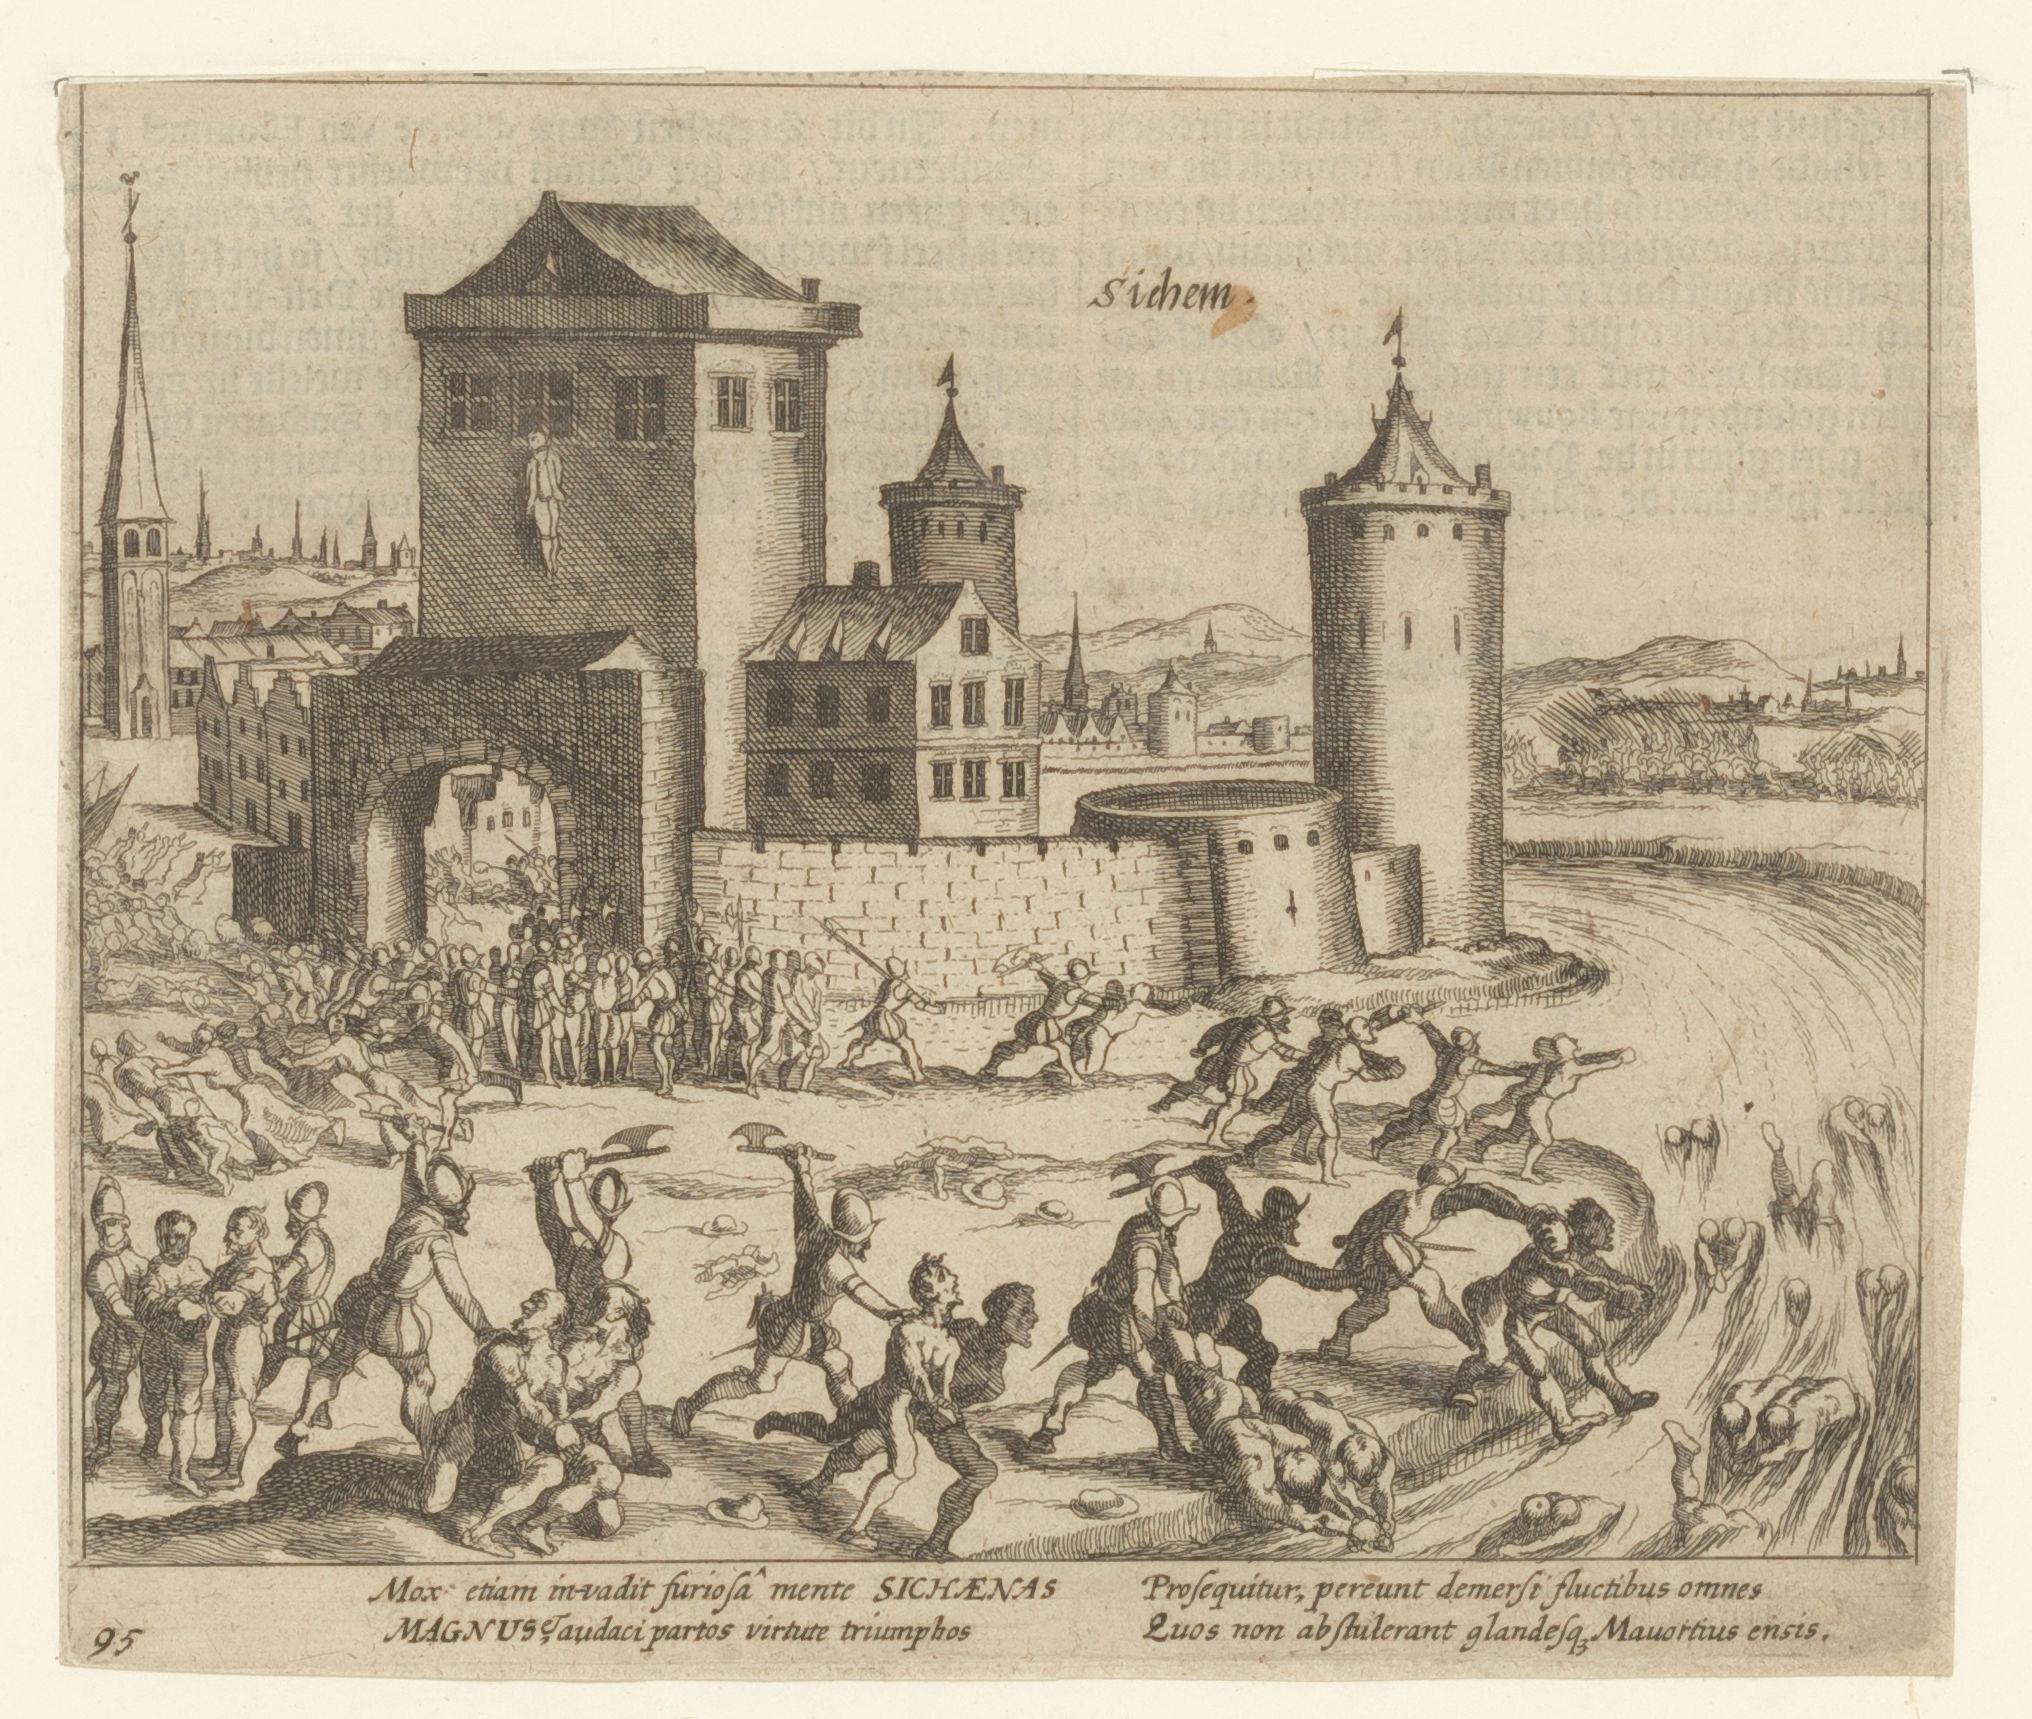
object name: history print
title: Bestraffing van Zichem, 1578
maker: simon frisius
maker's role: print maker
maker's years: 1570-1628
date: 1613-1615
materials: paper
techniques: etching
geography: northern netherlands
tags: rome, alessandro farnese (landvoogd van de nederlanden en hertog van parma en piacenza), massacre ~ war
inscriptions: collector's mark: Lugt 1641, collector's mark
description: Verovering en bestraffing van het plaatsje Zichem door de troepen van de hertog van Parma, 21 februari 1578. Buiten de stadspoort wordt een groot aantal burgers gedood en hun lichamen in de rivier gegooid. In de verte de stad Diest. Met onderschrift van 4 regels in het Latijn. Genummerd: 95. Bedrukt op achterzijde met tekst in het Nederlands. Onderwerpsrubrieken binnen de Atlas Zeden en Gewoonten: Krijgswezen; prenten van Baudart. 80j. oorlog.